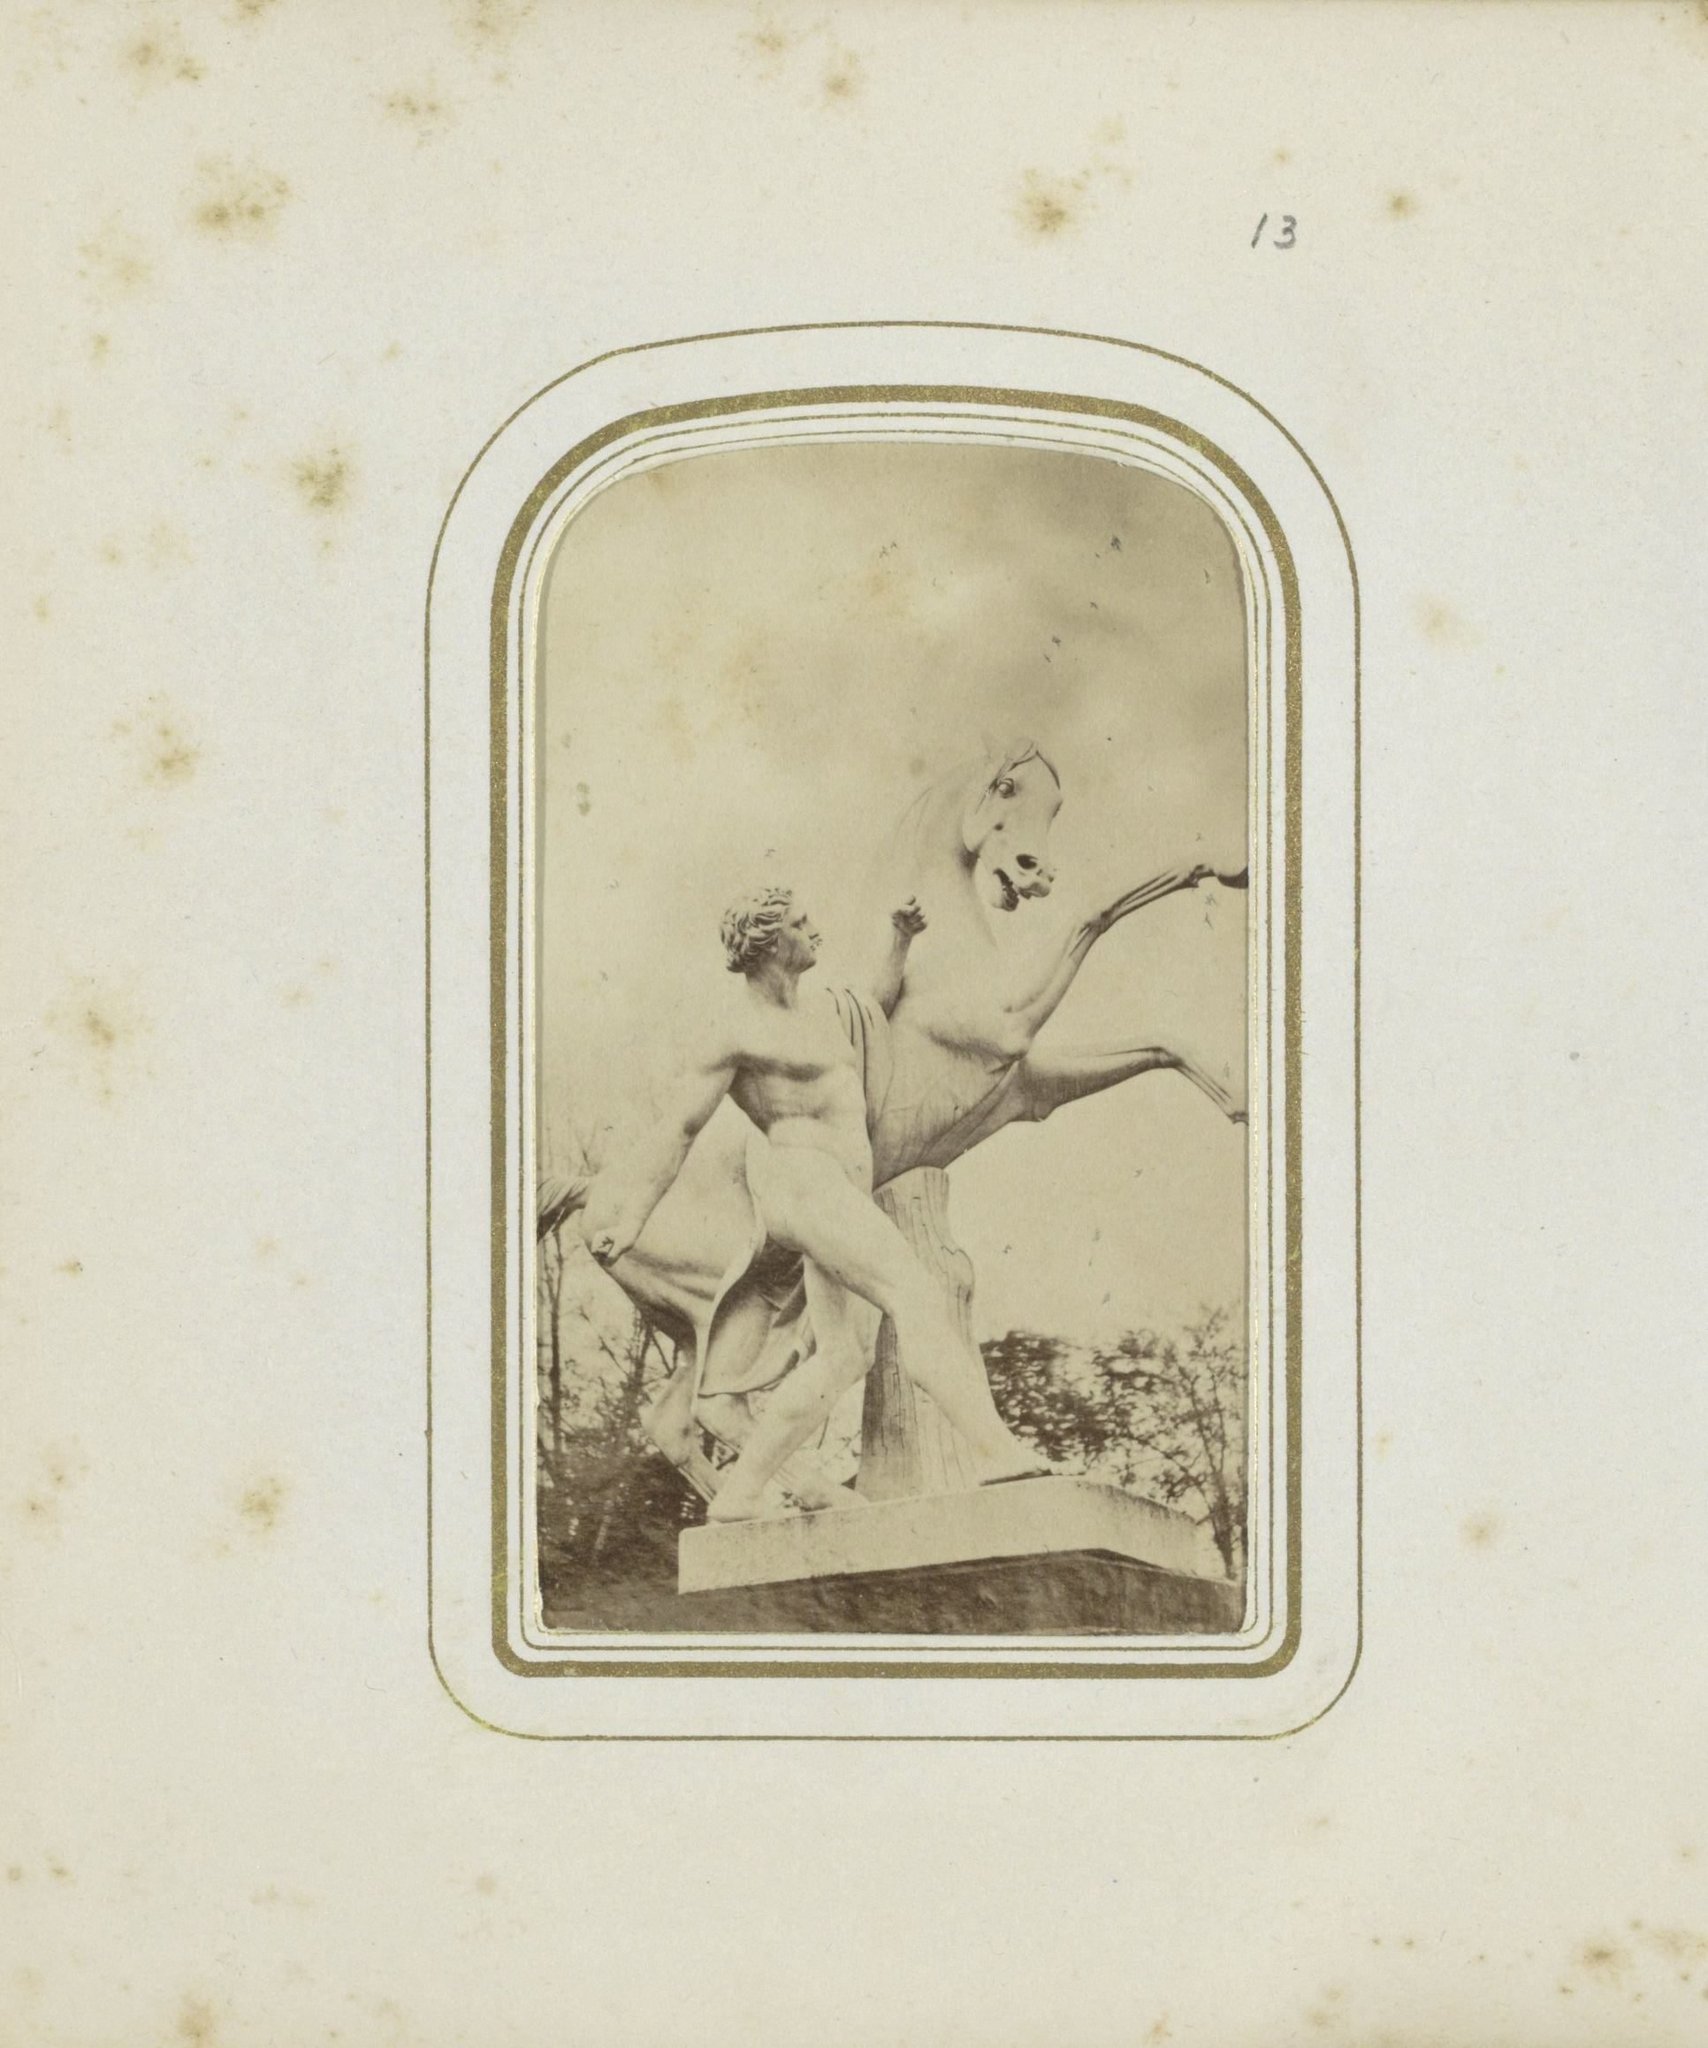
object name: photograph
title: Beeldhouwwerk van een paardentemmer in een park bij Bad Cannstatt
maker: Anonymous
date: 1865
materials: paper, photographic support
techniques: albumen print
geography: bad cannstatt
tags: monument, statue, travelling; tourism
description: Onderdeel van Fotoalbum van een reis door Zwitserland, Oostenrijk en Duitsland door de Nederlandse familie Derkinderen.